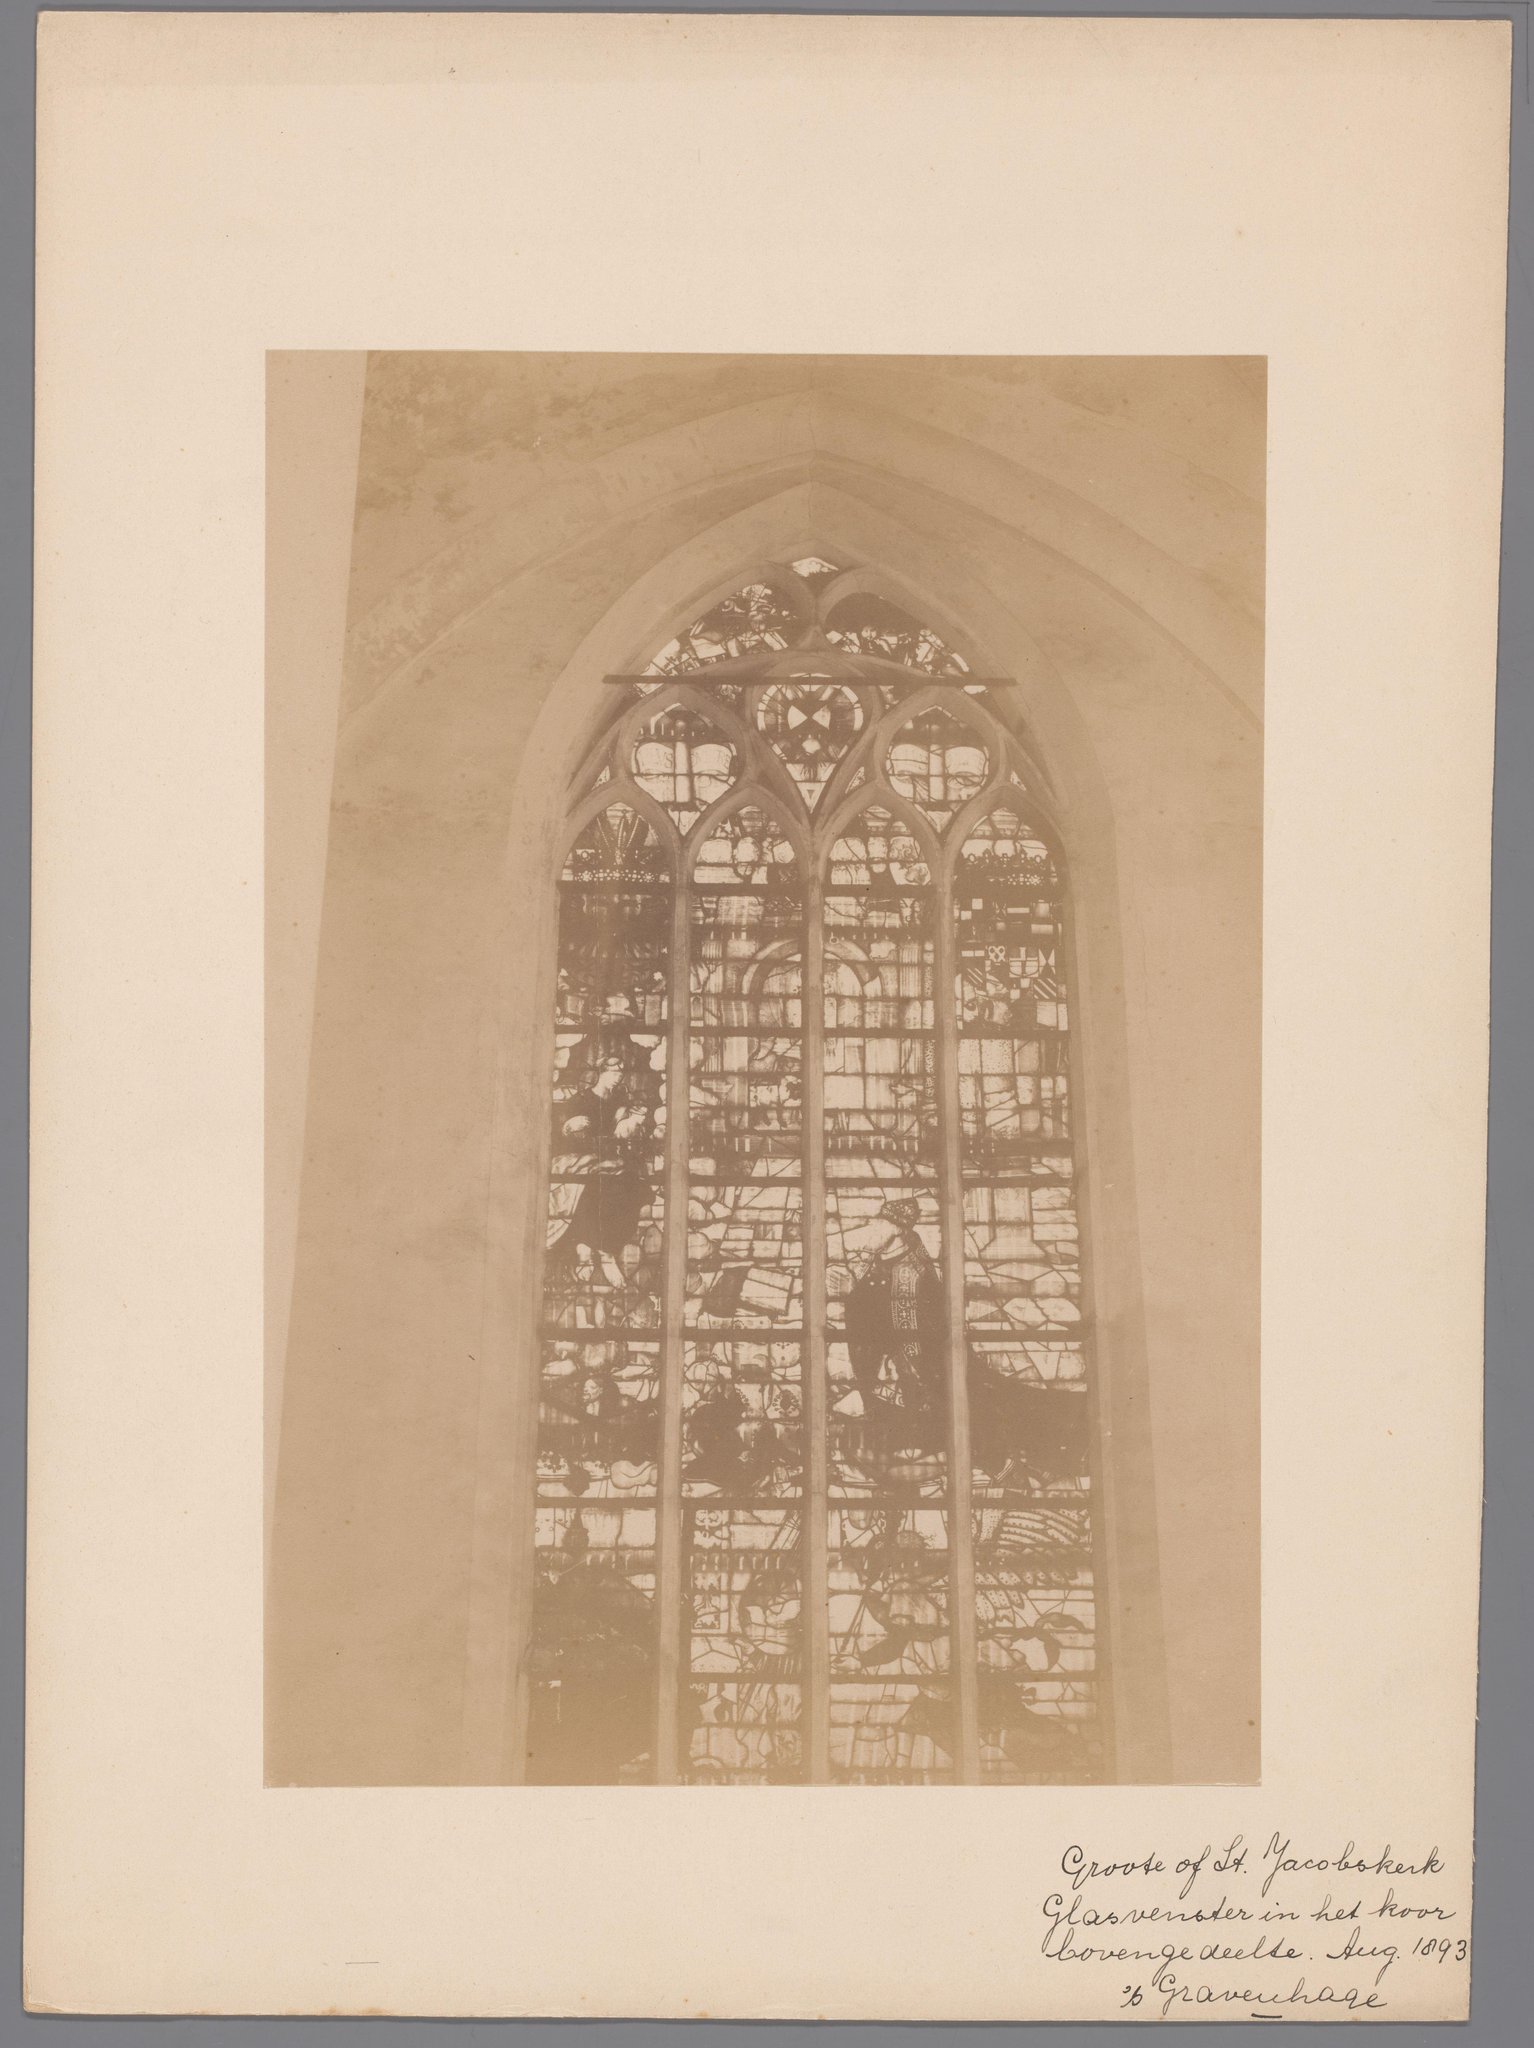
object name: photograph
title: Geschilderd raam in de Grote of Sint-Jacobskerk te Den Haag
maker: anoniem (monumentenzorg)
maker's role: fotograaf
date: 1893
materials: cardboard, photographic support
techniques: albumen print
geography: grote kerk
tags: church-window, e.g. rose-window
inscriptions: collector's mark: ‘R:MUS.’ Lugt 2228, annotation: ‘Groote of St. Jacobskerk/ glasvenster in het koor bovengedeelte Aug. 1893/ 's Gravenhage’, annotation: ‘Glasvenster in het koor (bovengedeelte)/ Aug 1893/ S. Jacobskerk te 's Gravenhage (Z.H.)’